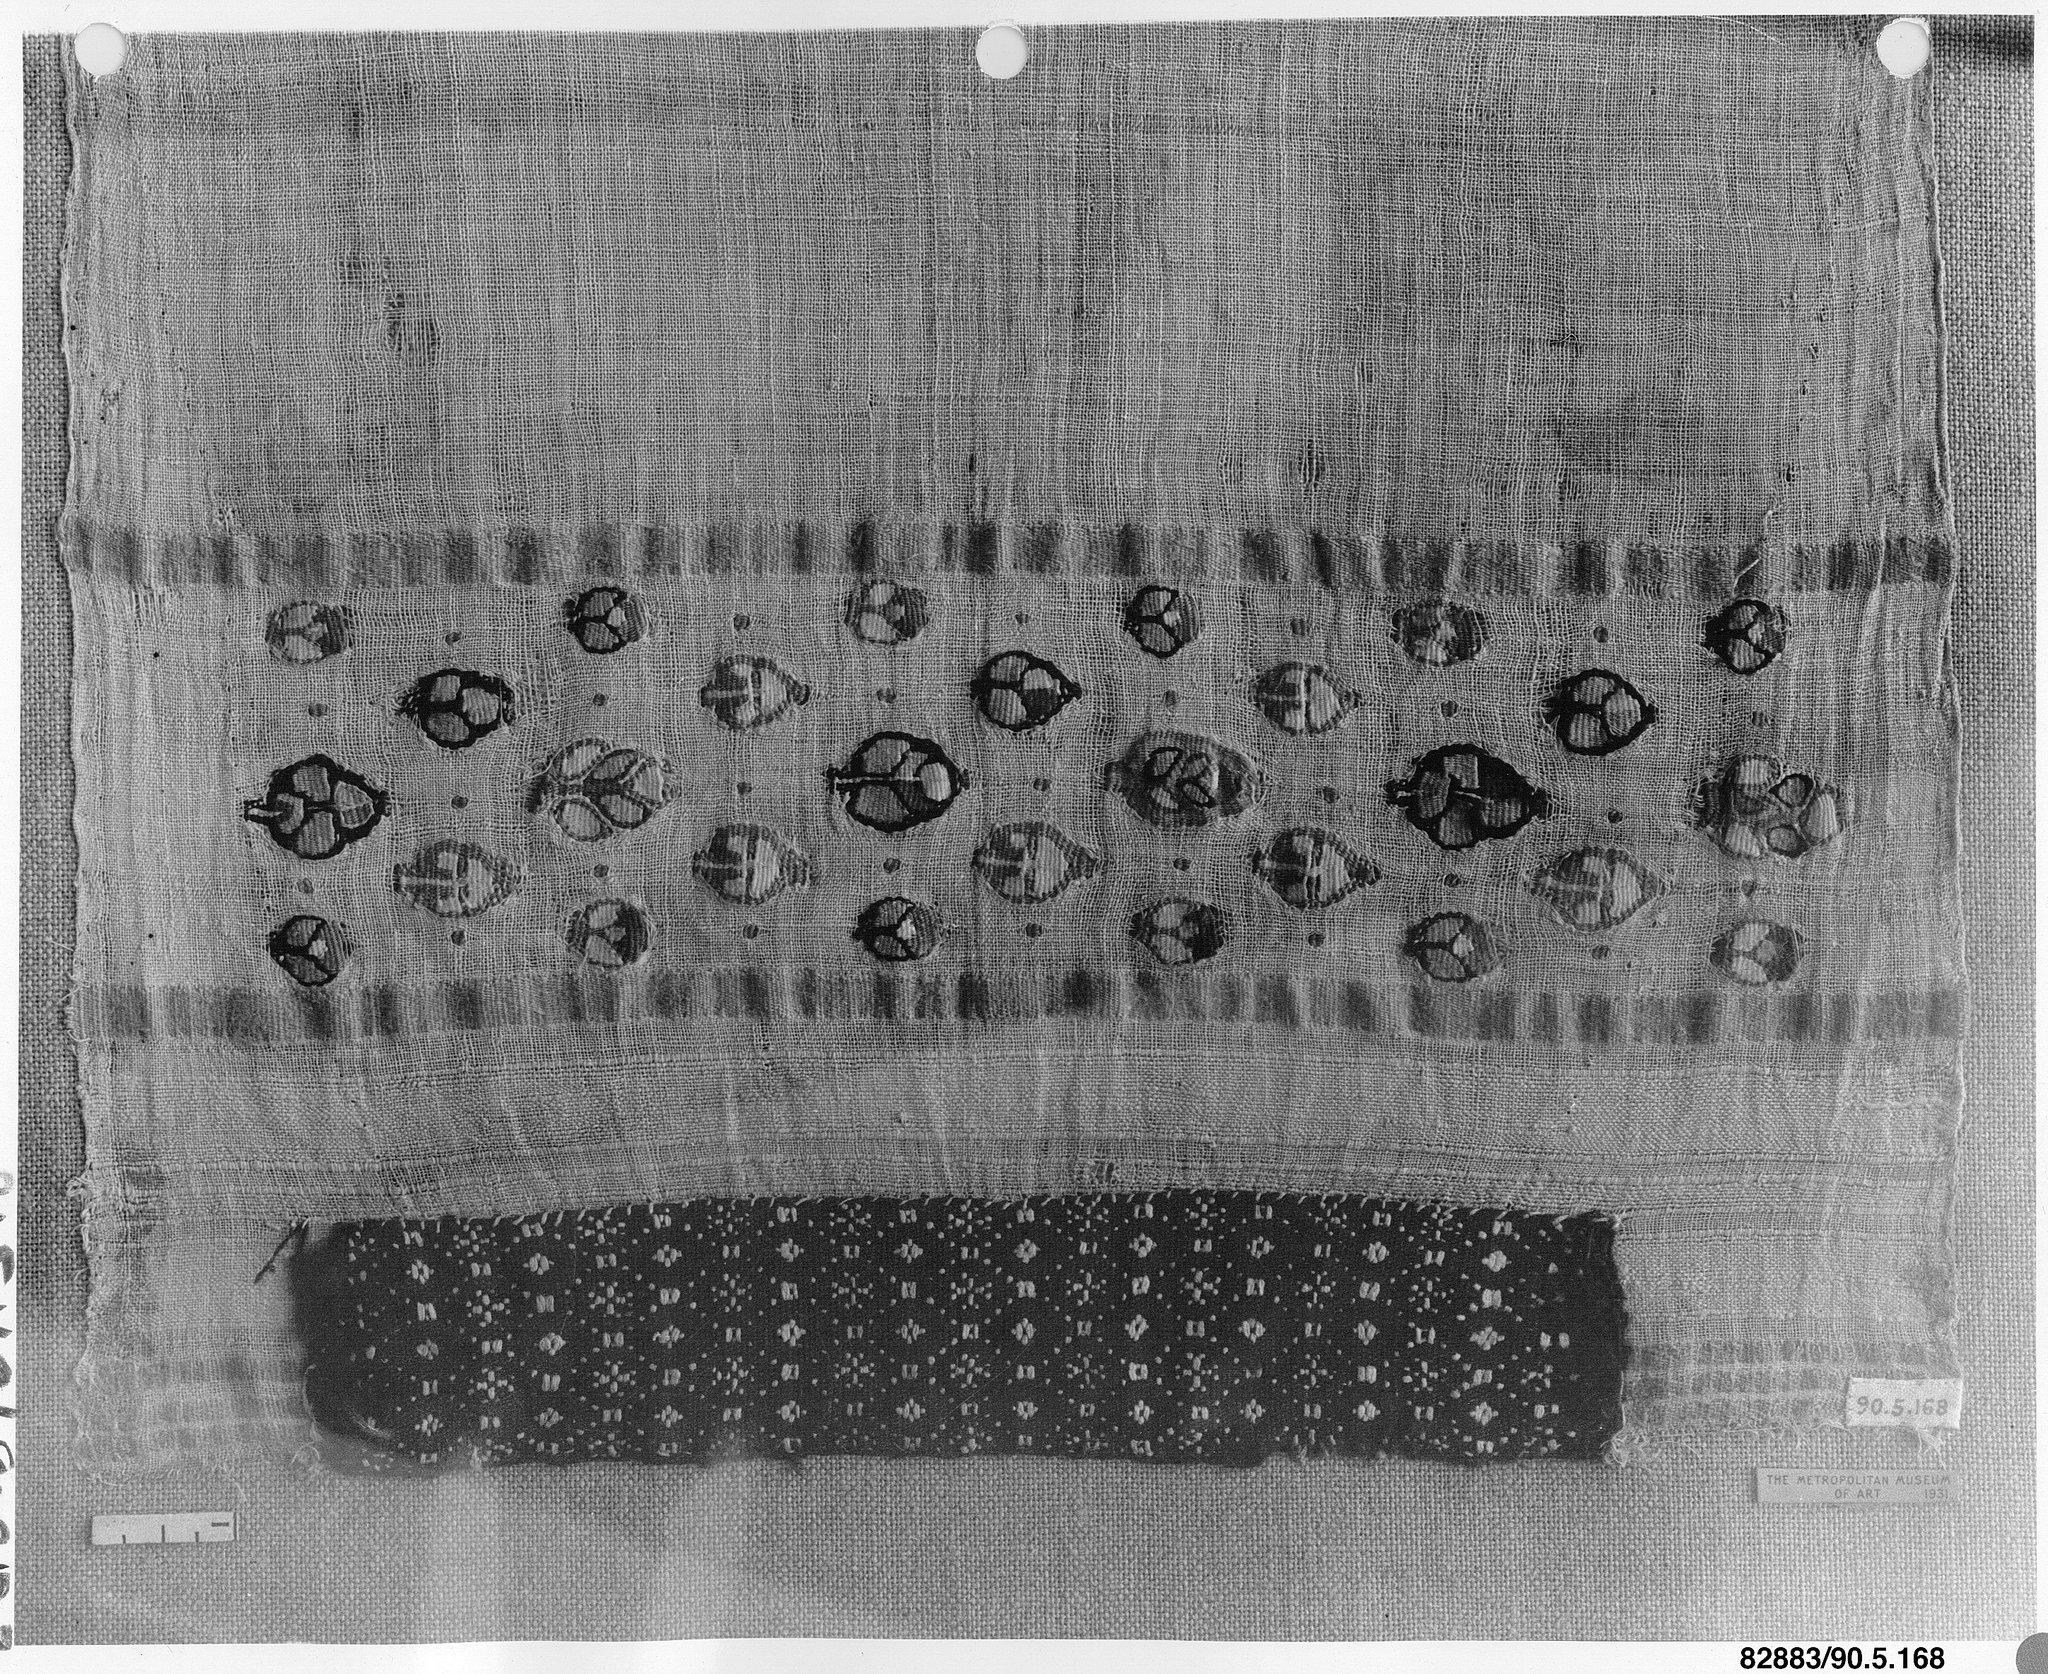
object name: textile fragment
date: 401-600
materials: linen, wool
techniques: weave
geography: egypt